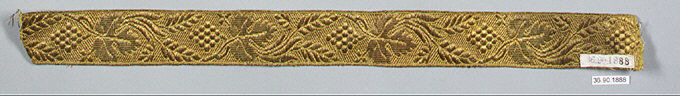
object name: galloon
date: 1767-1833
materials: metal thread